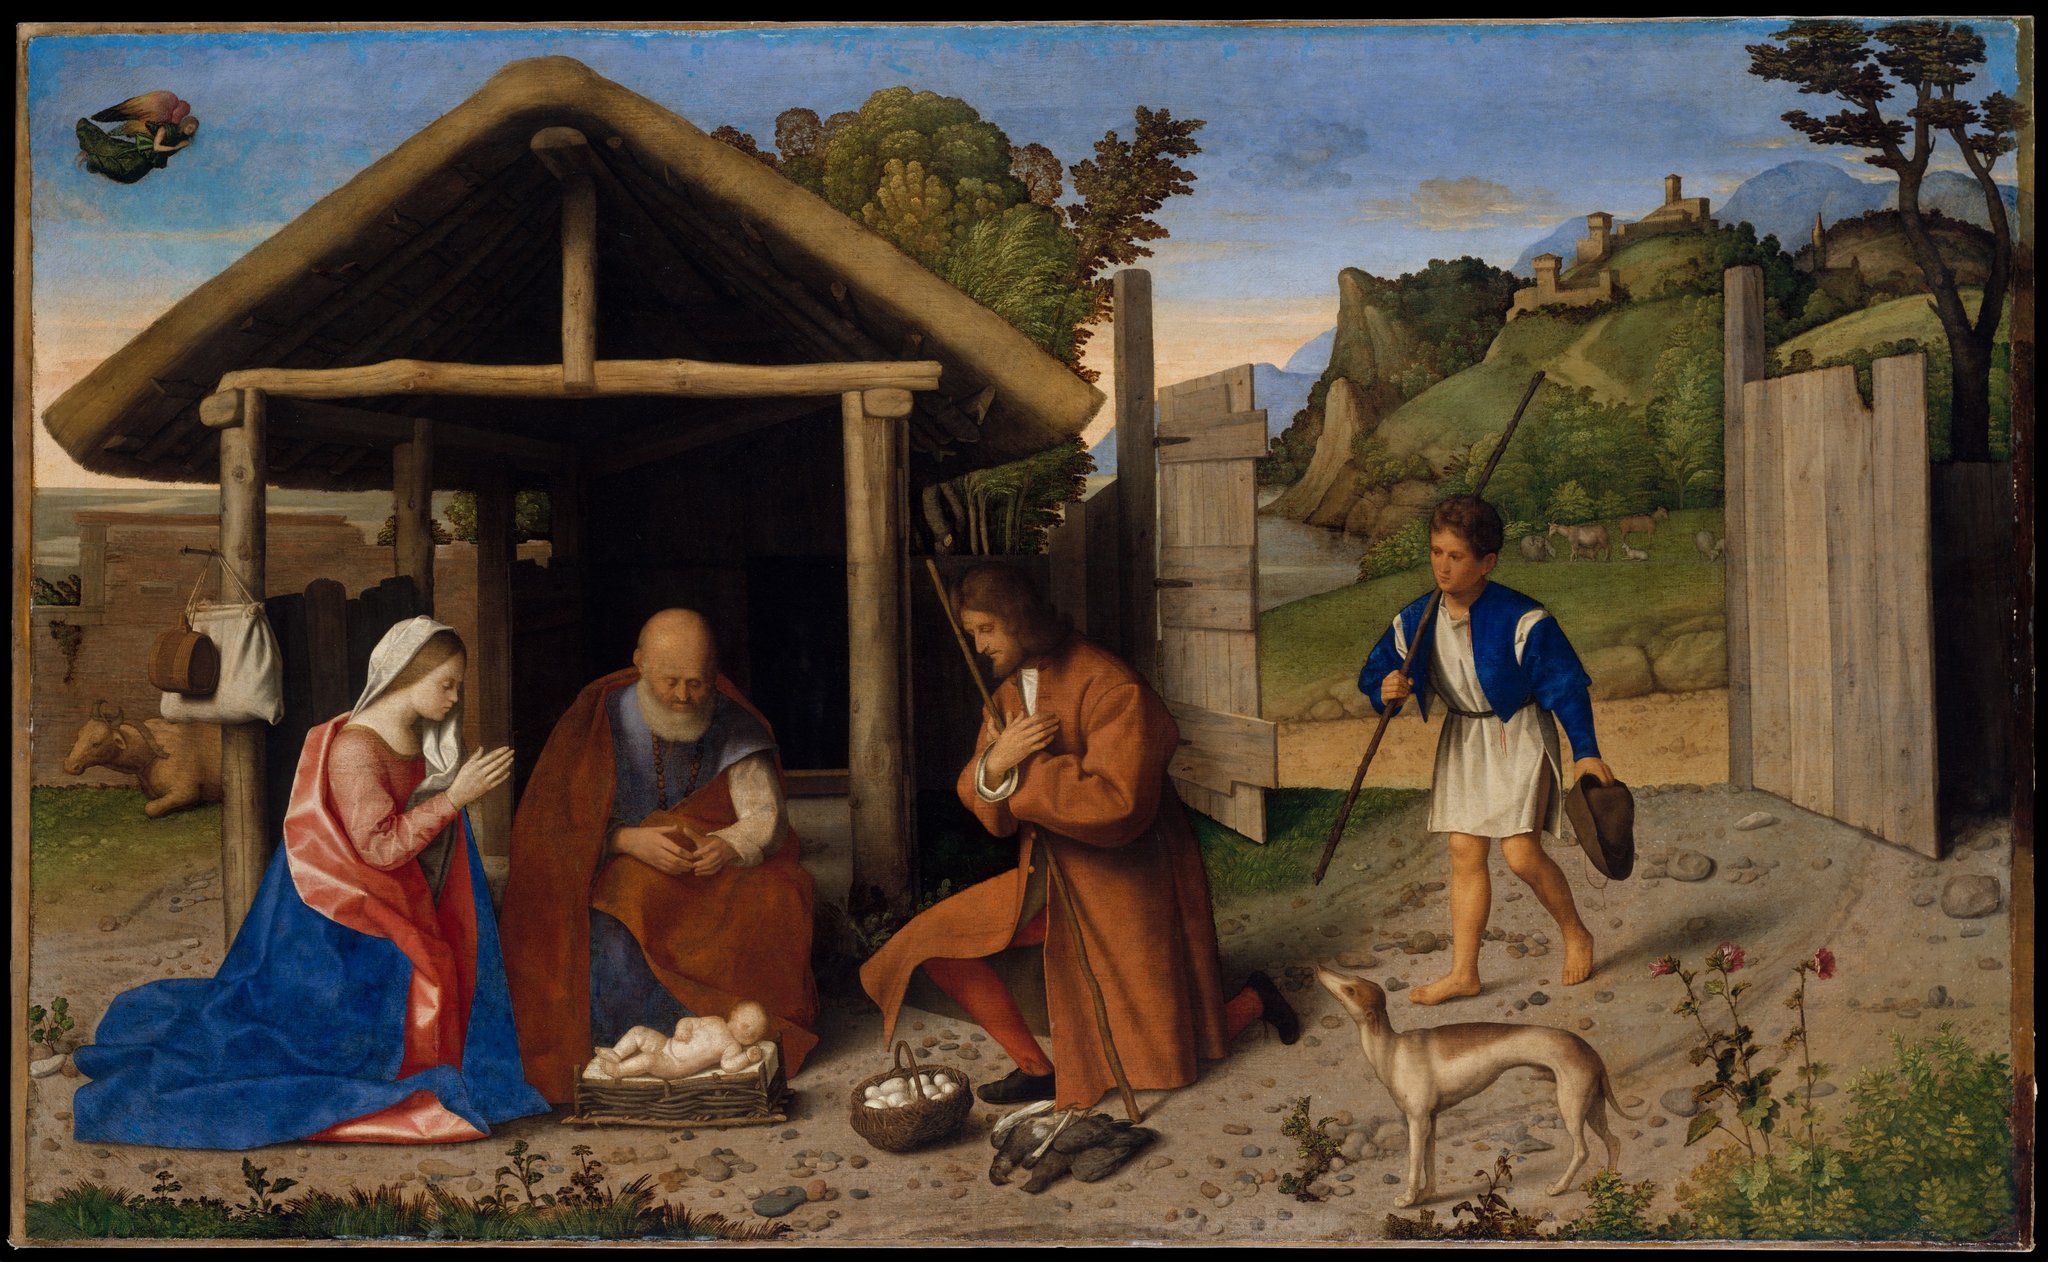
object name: painting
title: The Adoration of the Shepherds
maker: catena (vincenzo di biagio)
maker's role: artist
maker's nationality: italian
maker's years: 1506-1531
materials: canvas, oil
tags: men,dogs,virgin mary,jesus,adoration of the shepherds,joseph